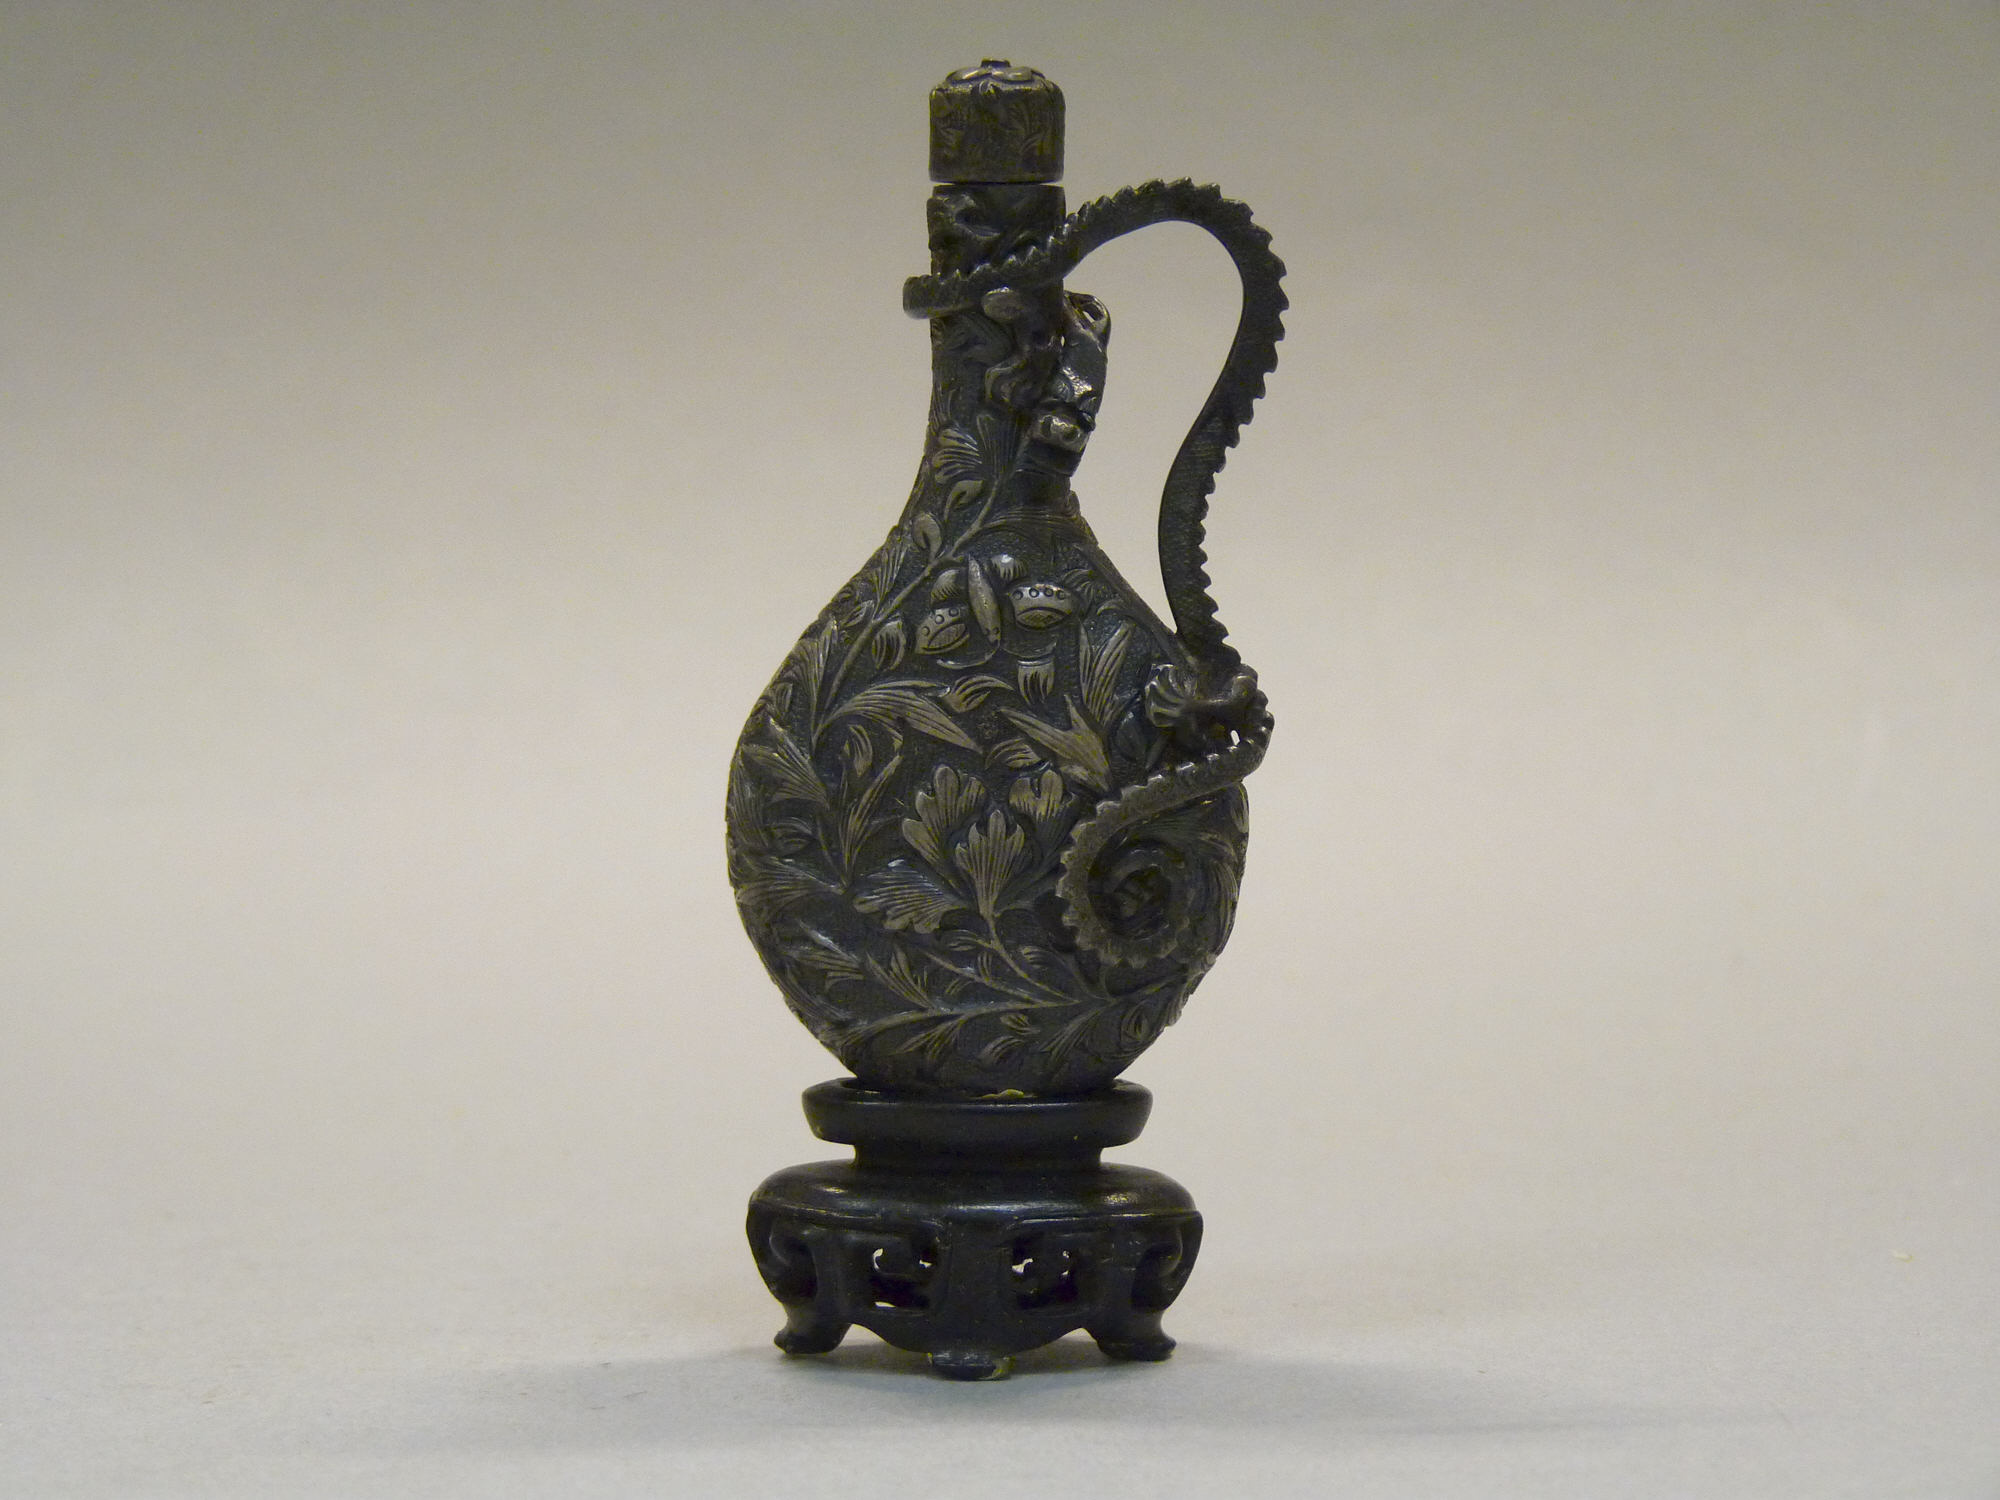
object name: snuff bottle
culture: chinese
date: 1900-1920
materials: silver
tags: dragons,plants